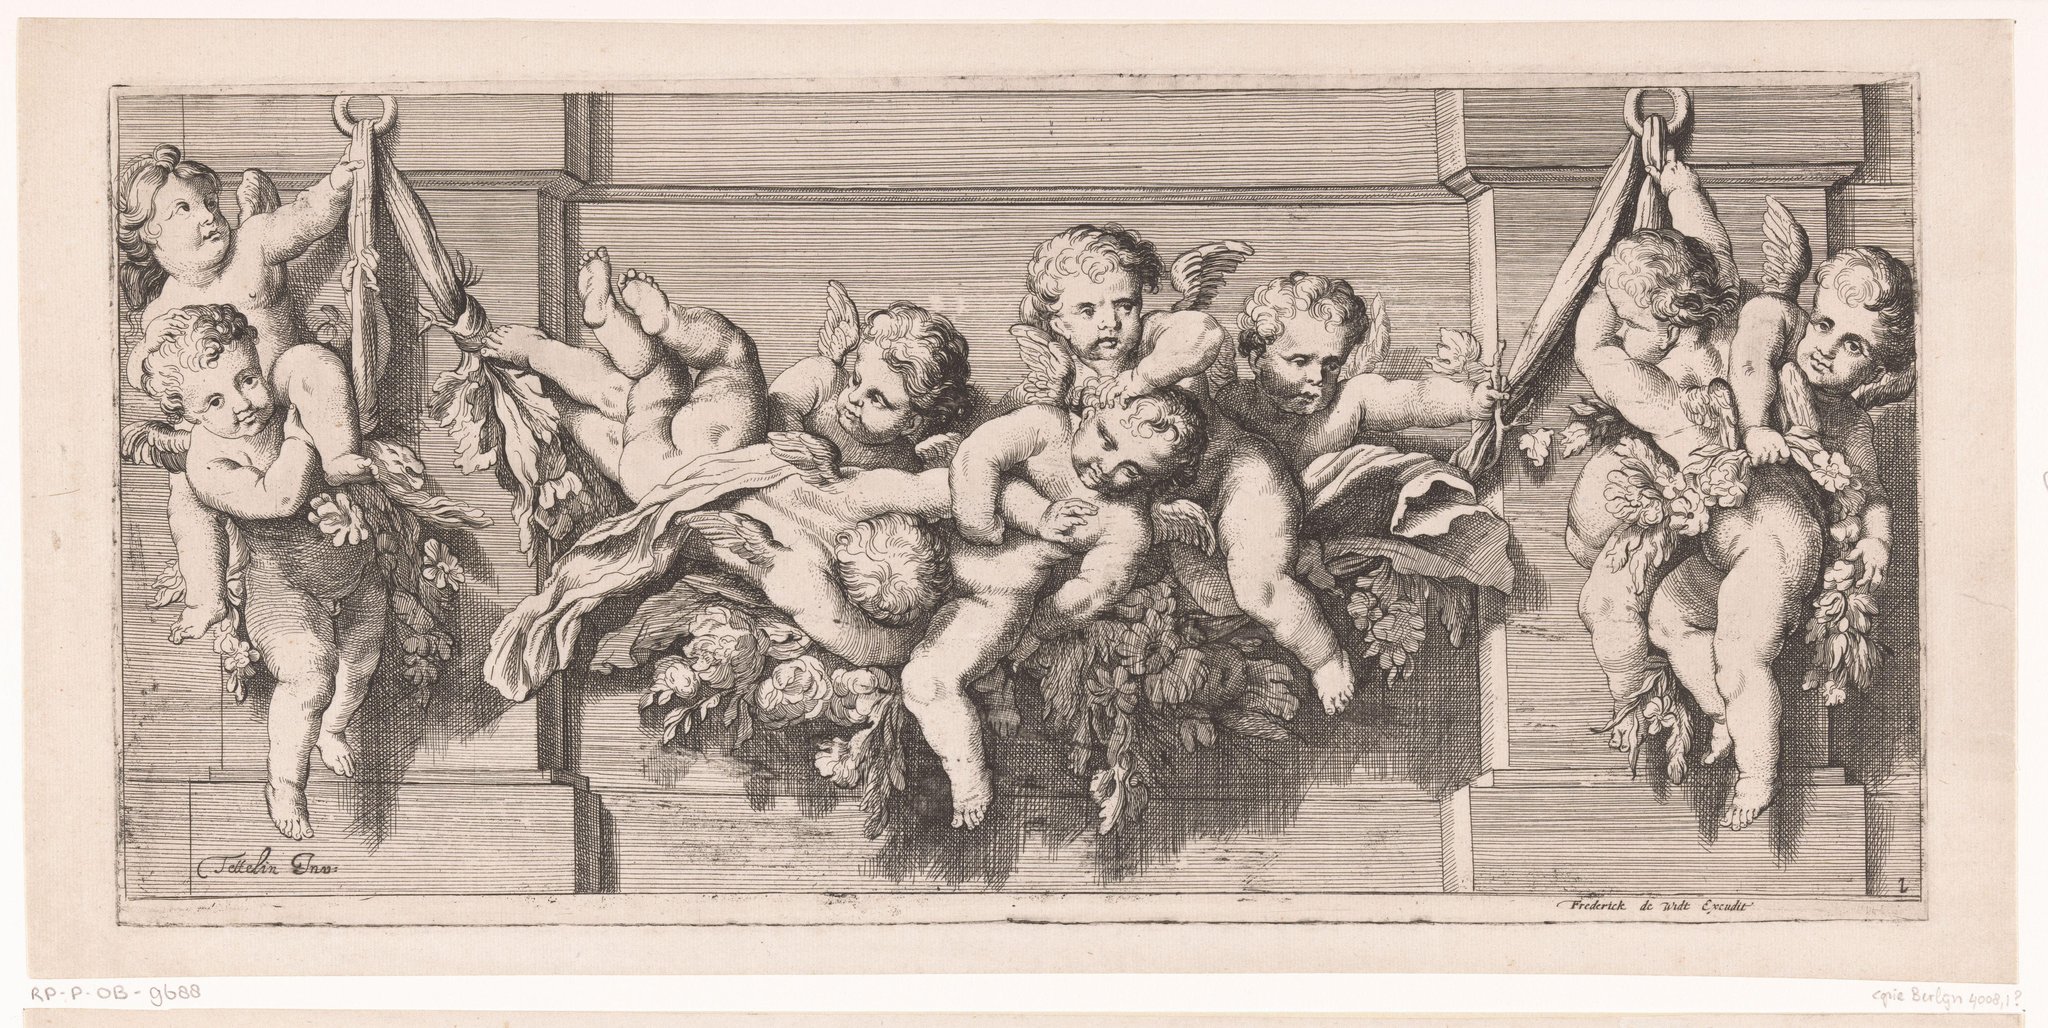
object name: ornament print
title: Friezen met putti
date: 1639-1706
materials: paper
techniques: etching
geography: amsterdam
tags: ornament ~ festoon, garland, cupids: 'amores', 'amoretti', 'putti'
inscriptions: collector's mark: Lugt 240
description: Een fries met putti hangend op en aan een guirlande.